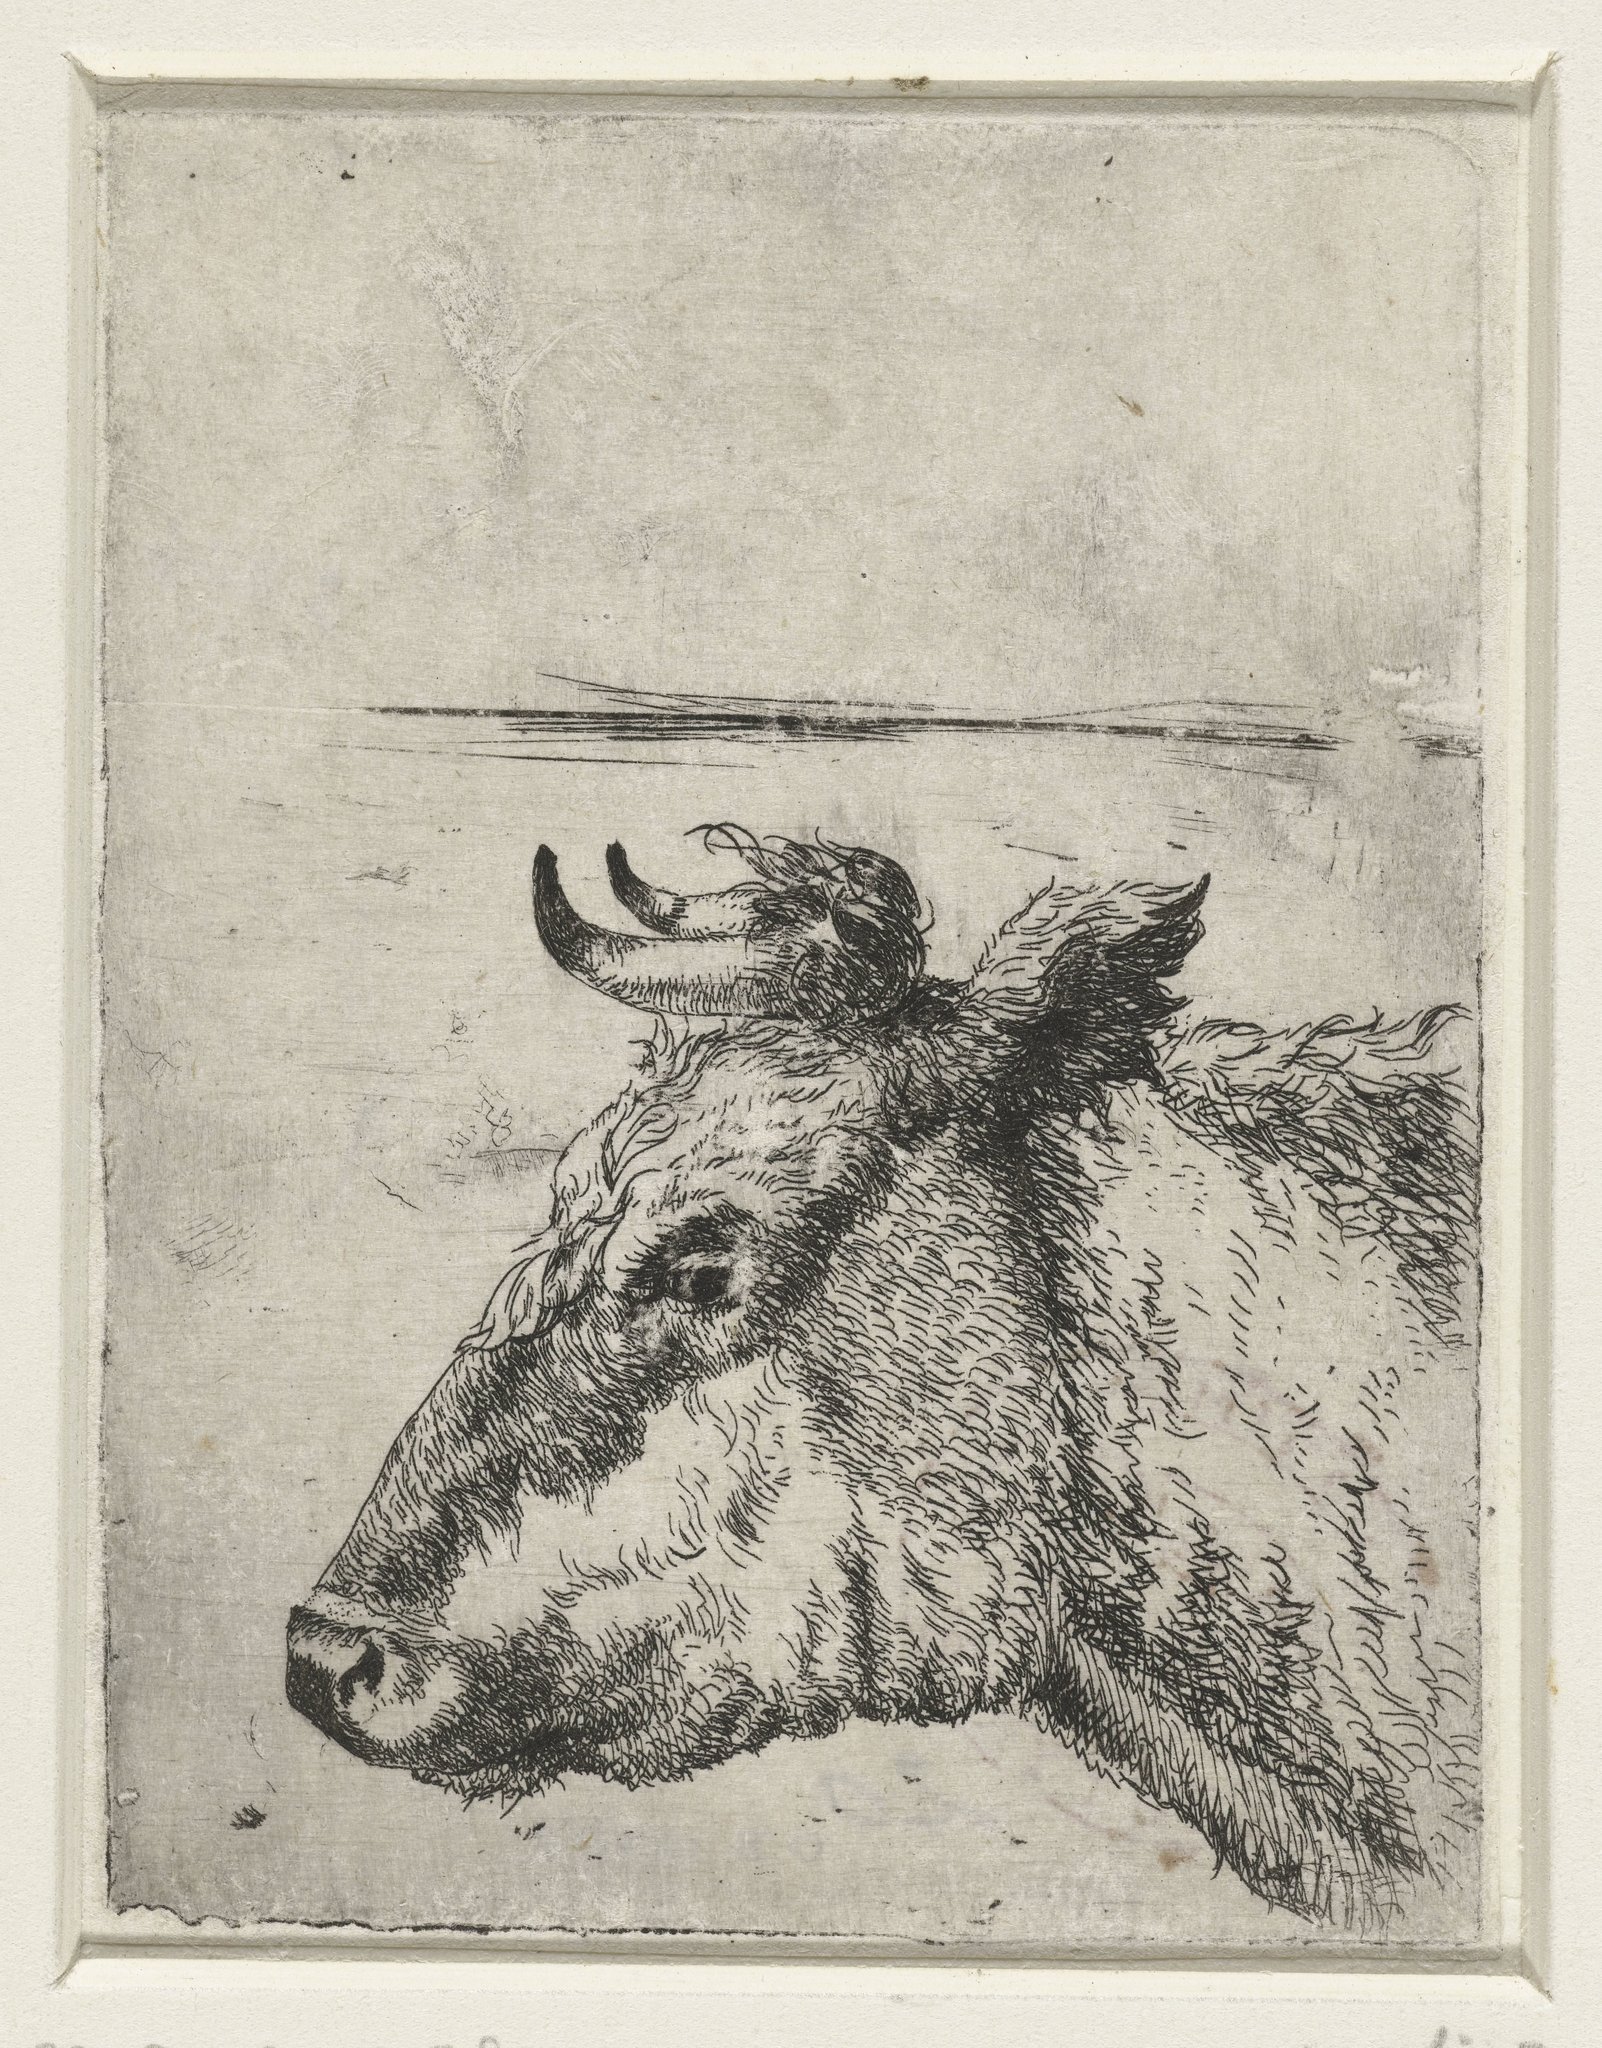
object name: print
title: Kop van een koe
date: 1635-1688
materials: paper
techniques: etching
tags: cow, animals (+ head of an animal)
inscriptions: collector's mark: Lugt 240